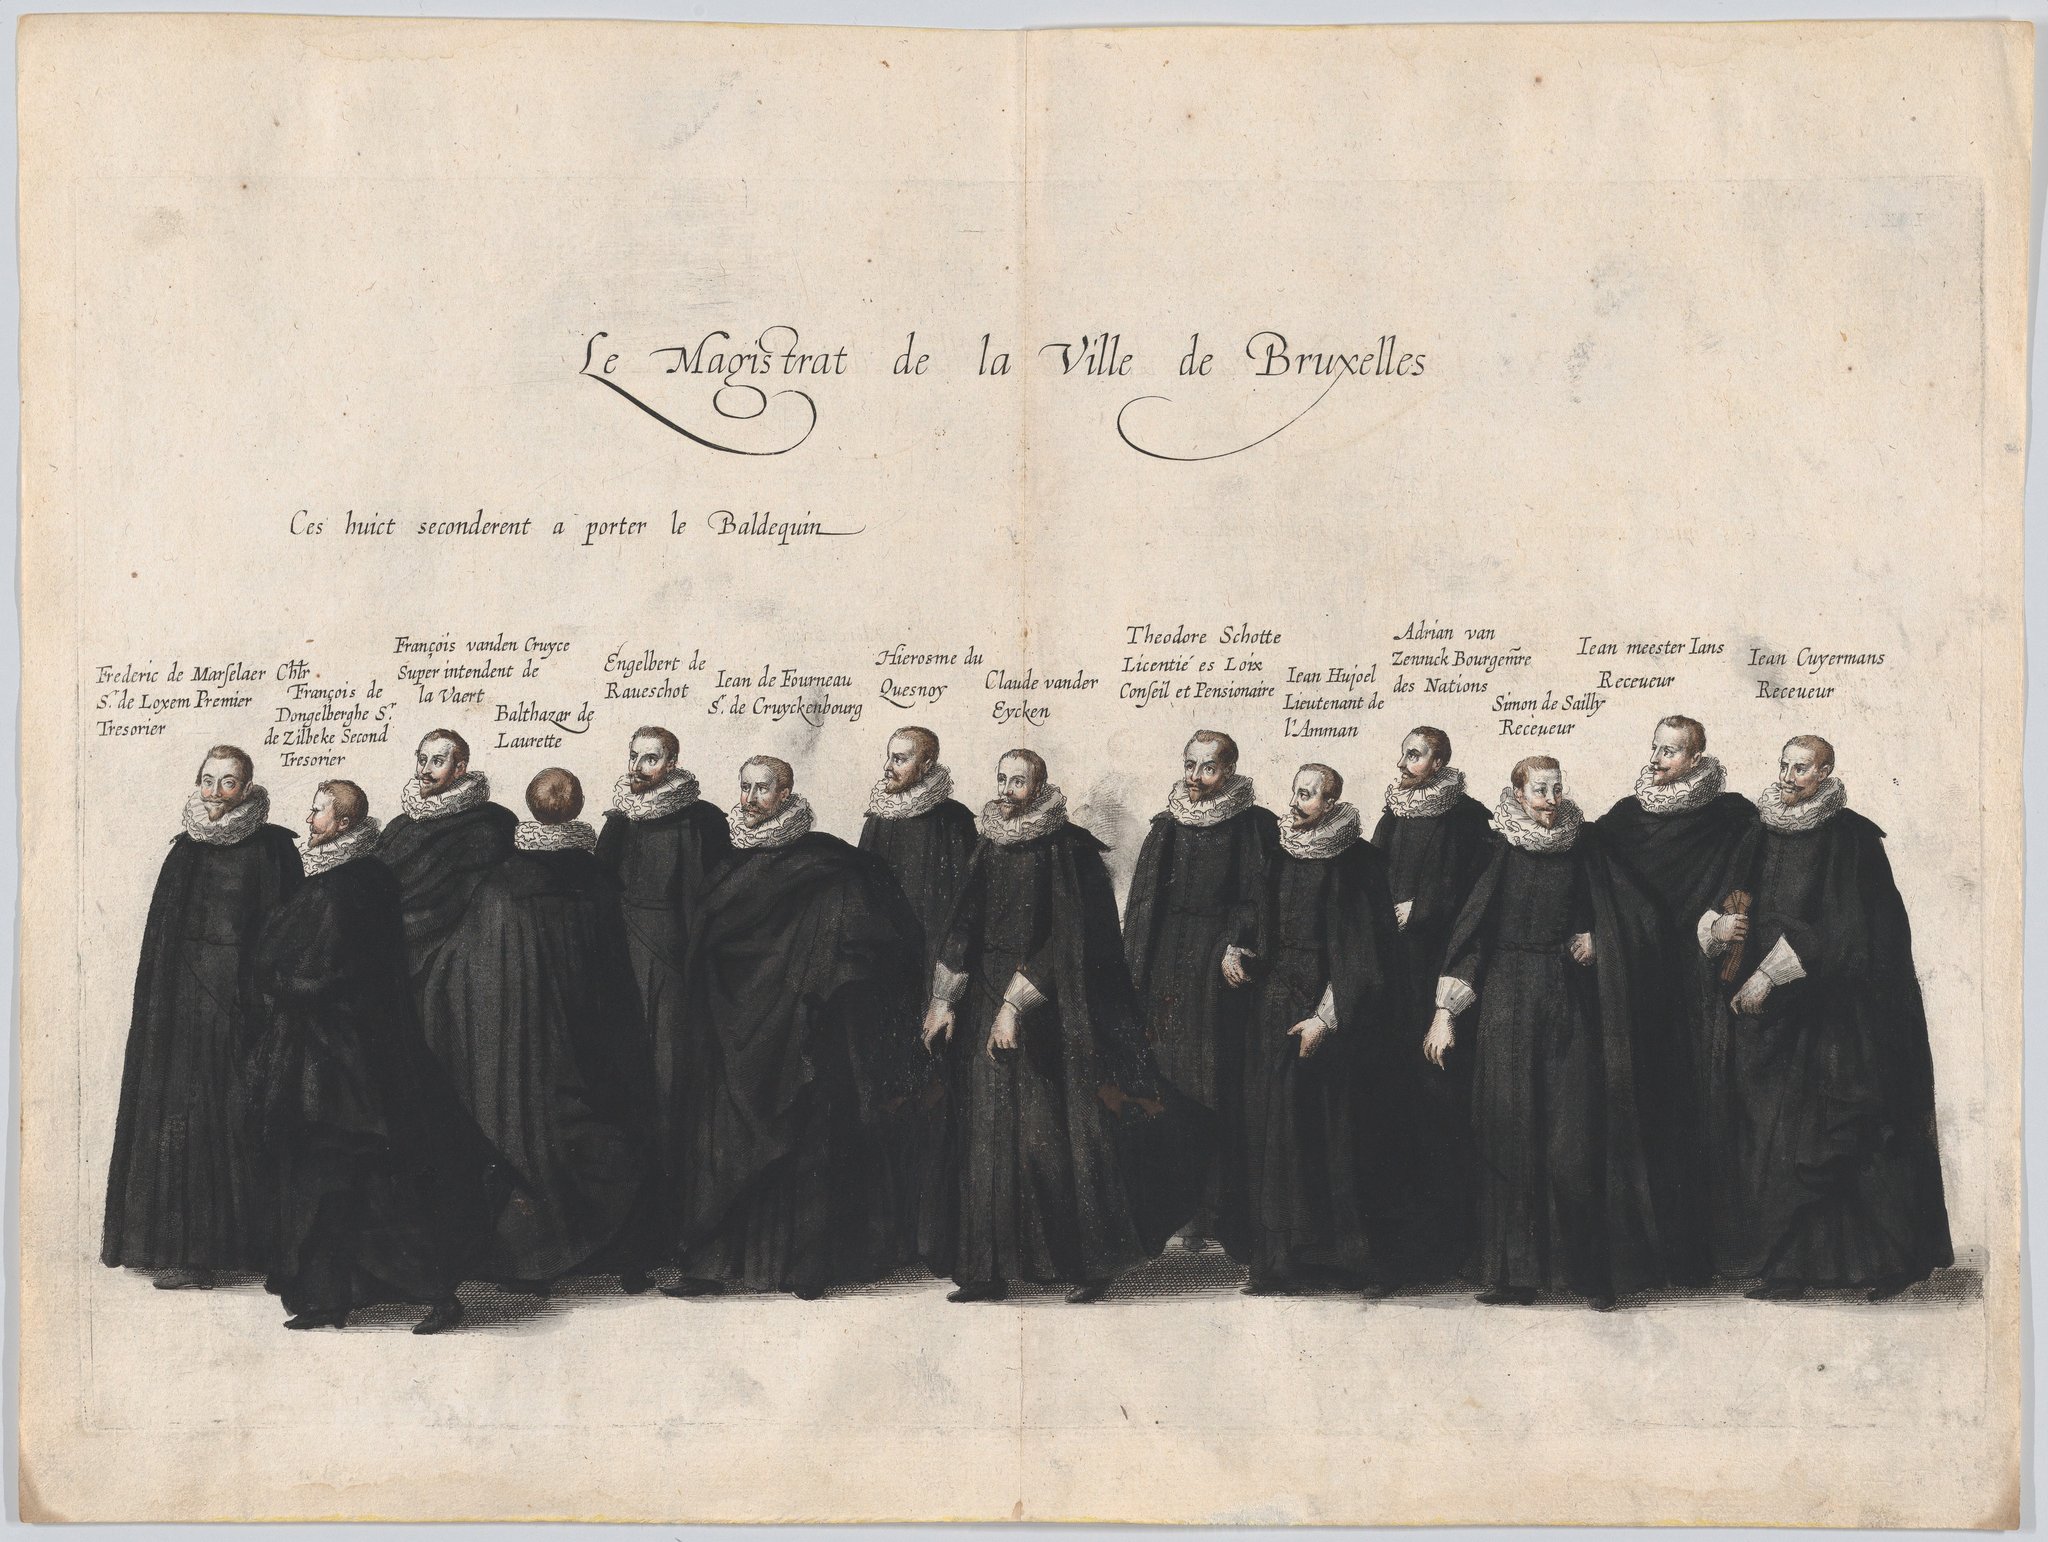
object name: print, fete, ornament architecture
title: Plate 63: The magistrates of the city of Brussels marching in the funeral procession of Archduke Albert of Austria; from 'Pompa Funebris ... Alberti Pii'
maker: cornelis galle (i)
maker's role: artist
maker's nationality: netherlandish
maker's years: 1576-1650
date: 1623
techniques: etching, hand coloring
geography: brussels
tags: men